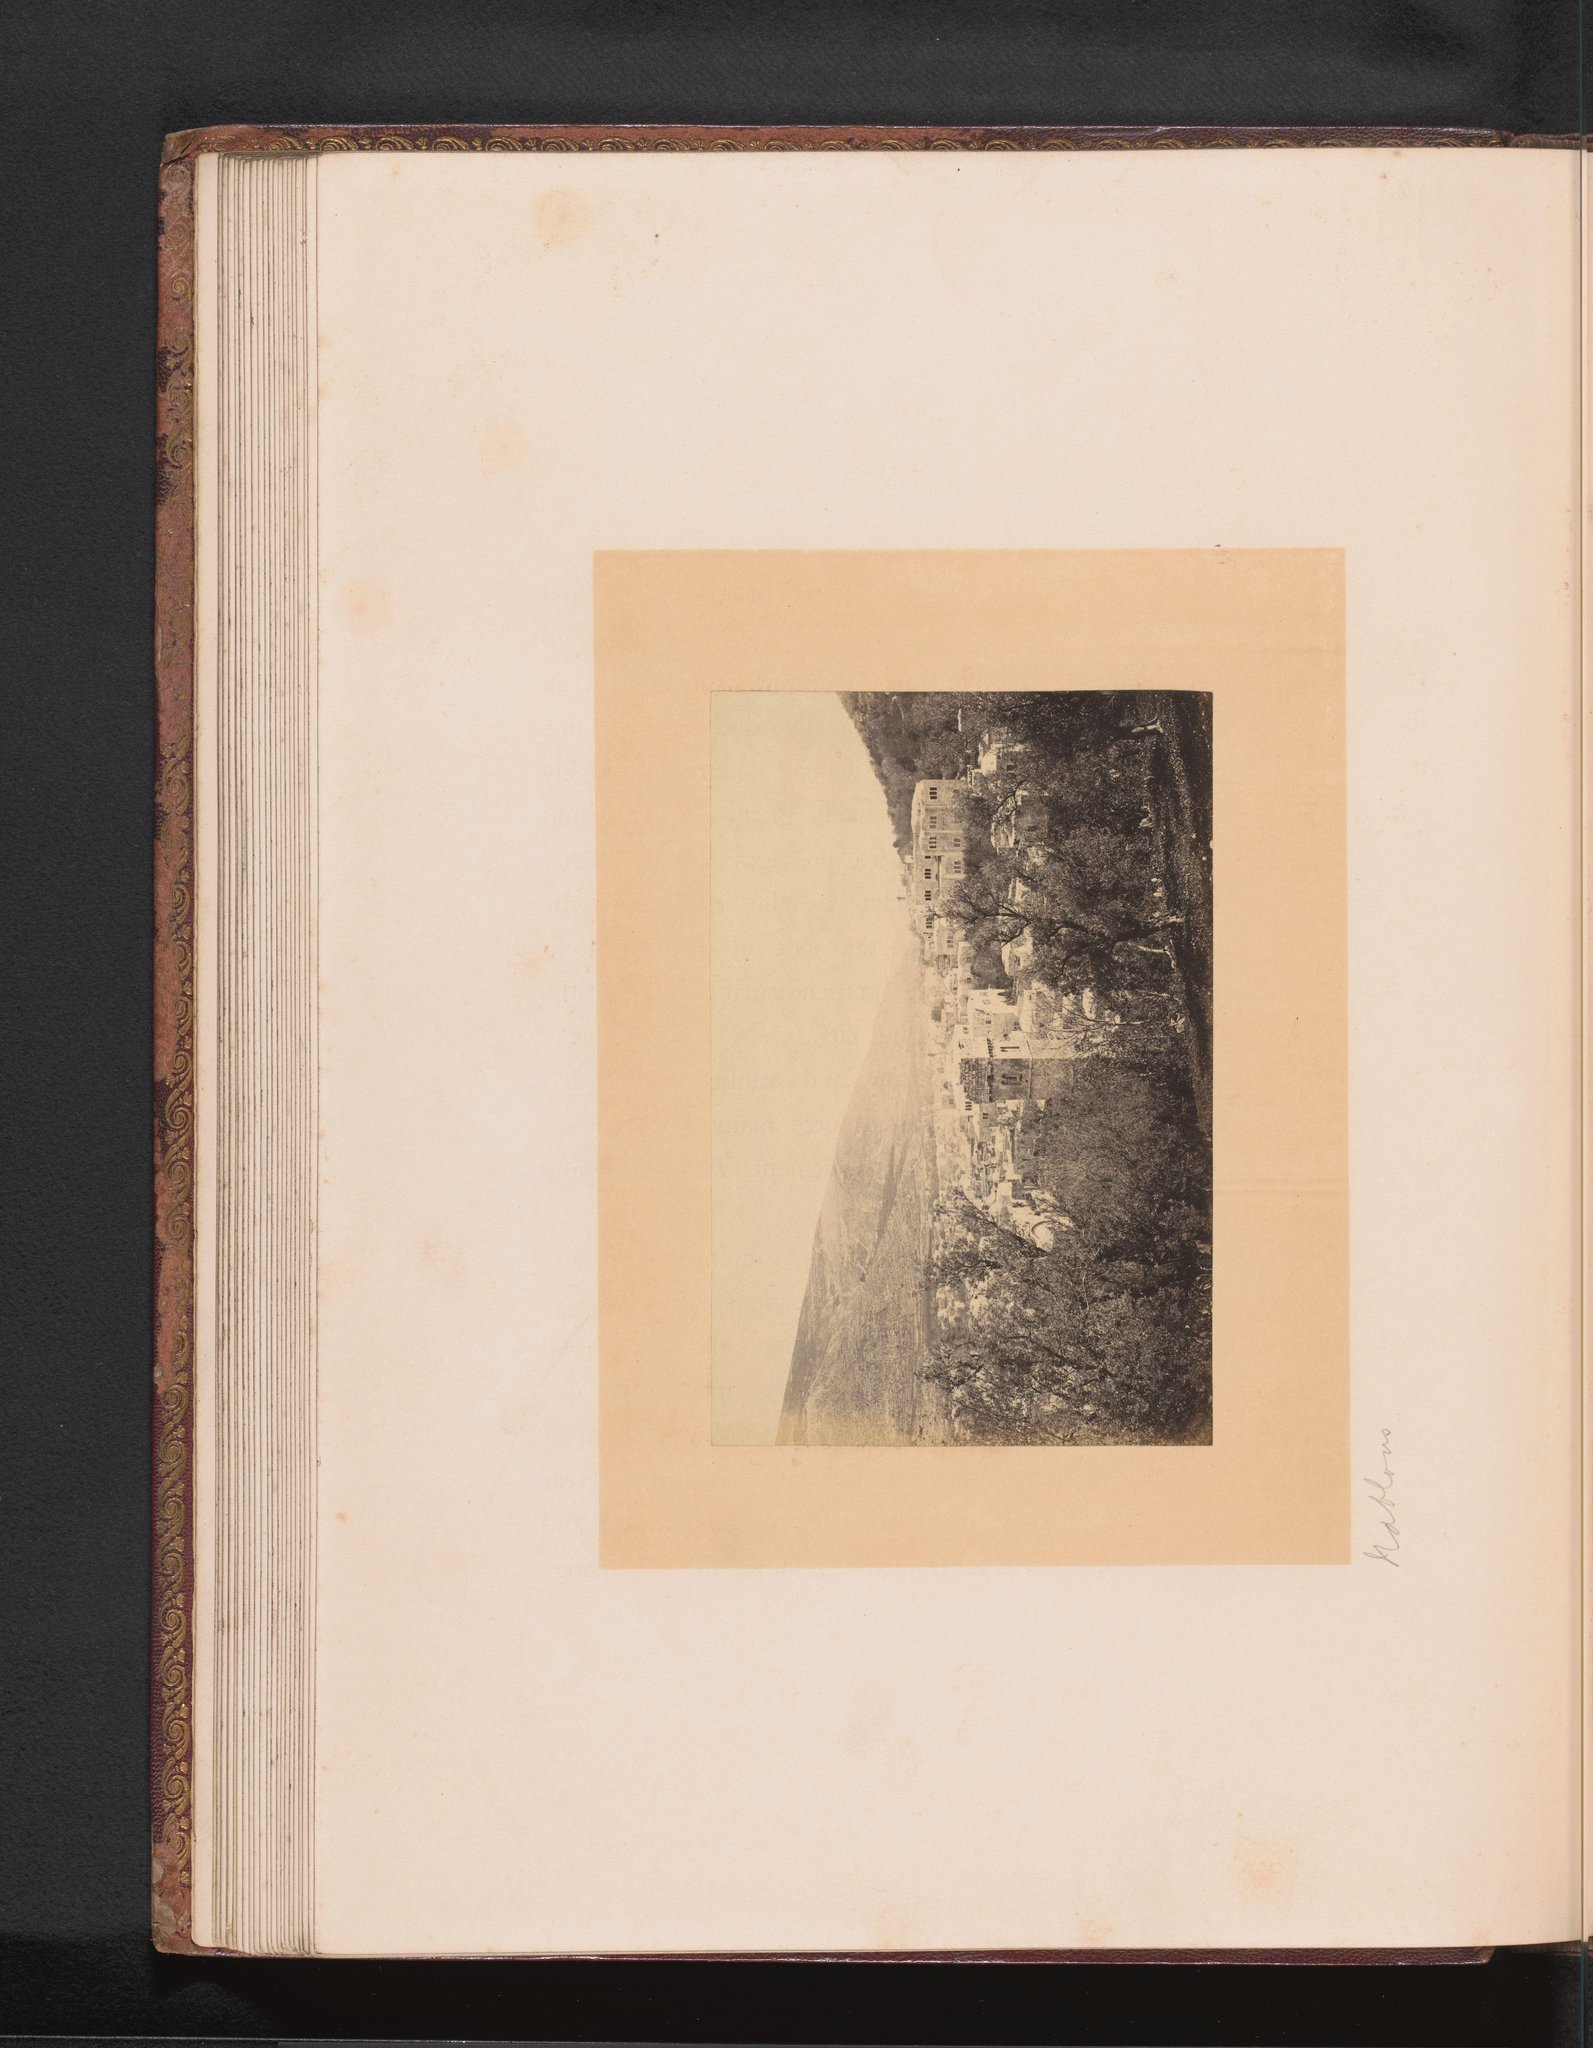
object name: photograph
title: Gezicht op Nablus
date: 1870-1875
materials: photographic support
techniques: albumen print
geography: nablus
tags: city-view in general; 'veduta'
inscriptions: annotation: ‘Nablus’